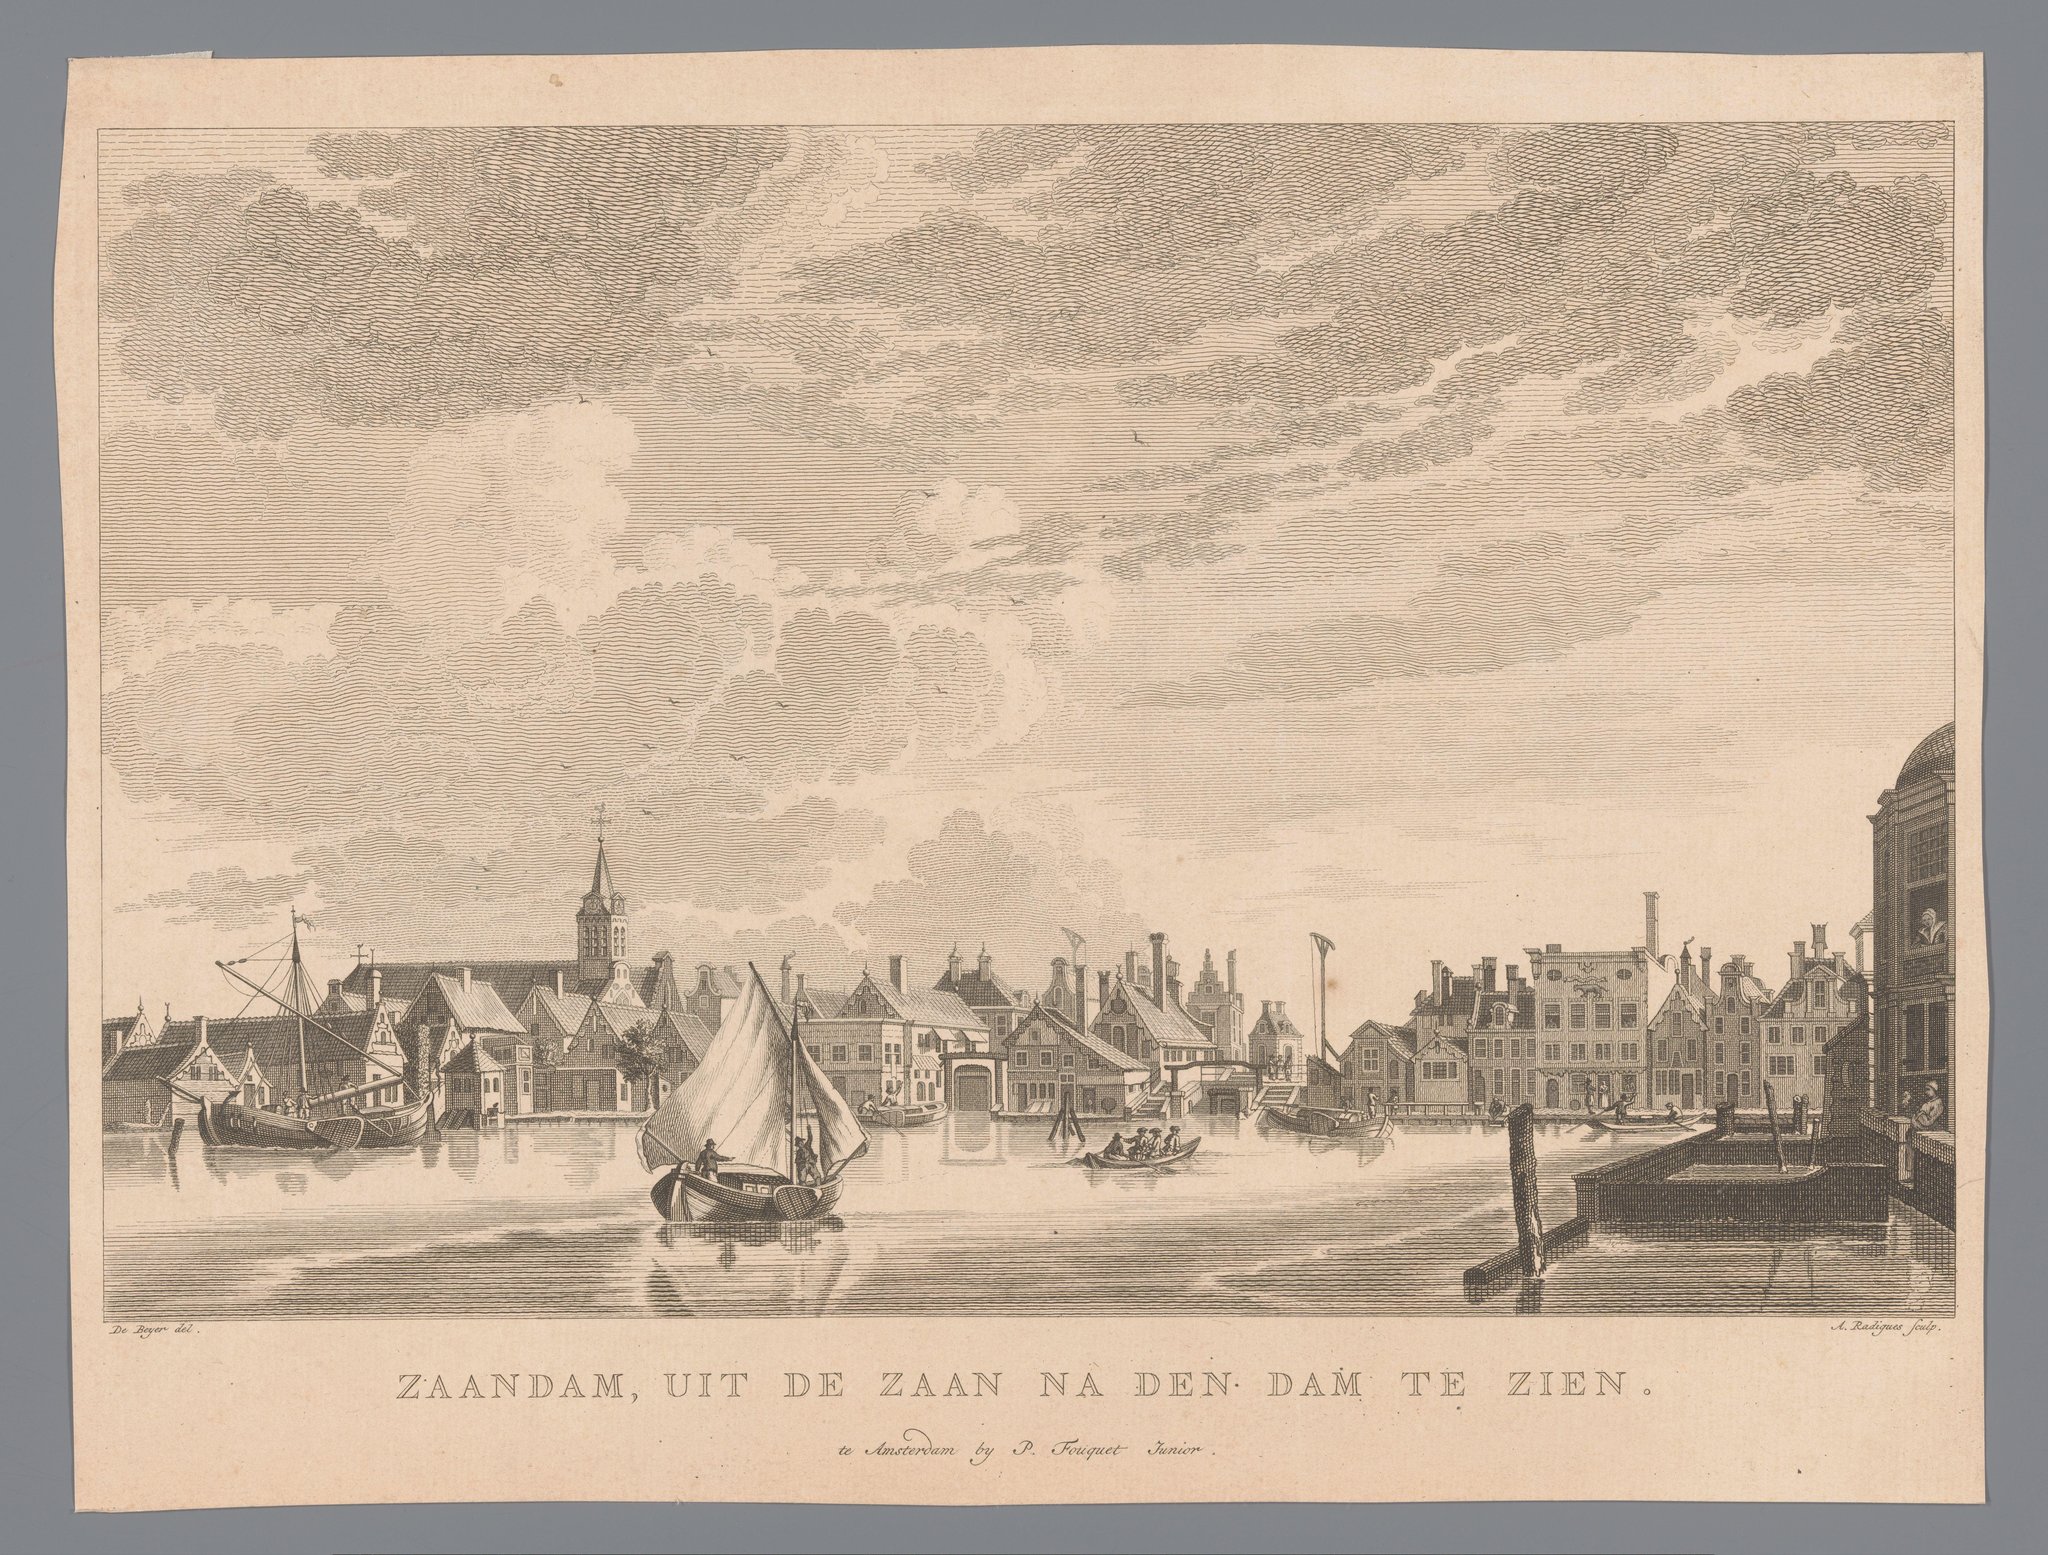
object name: print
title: Zaandam, uit de Zaan na den dam te zien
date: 1753-1800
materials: paper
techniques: etching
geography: amsterdam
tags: city-view, and landscape with man-made constructions, ships (in general)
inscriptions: collector's mark: Lugt 2228